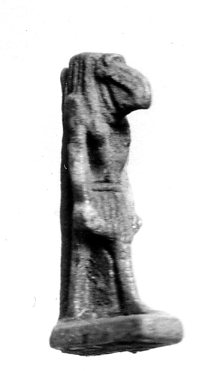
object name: amulet, thoth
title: Thoth amulet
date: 664-630 BCE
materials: faience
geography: egypt